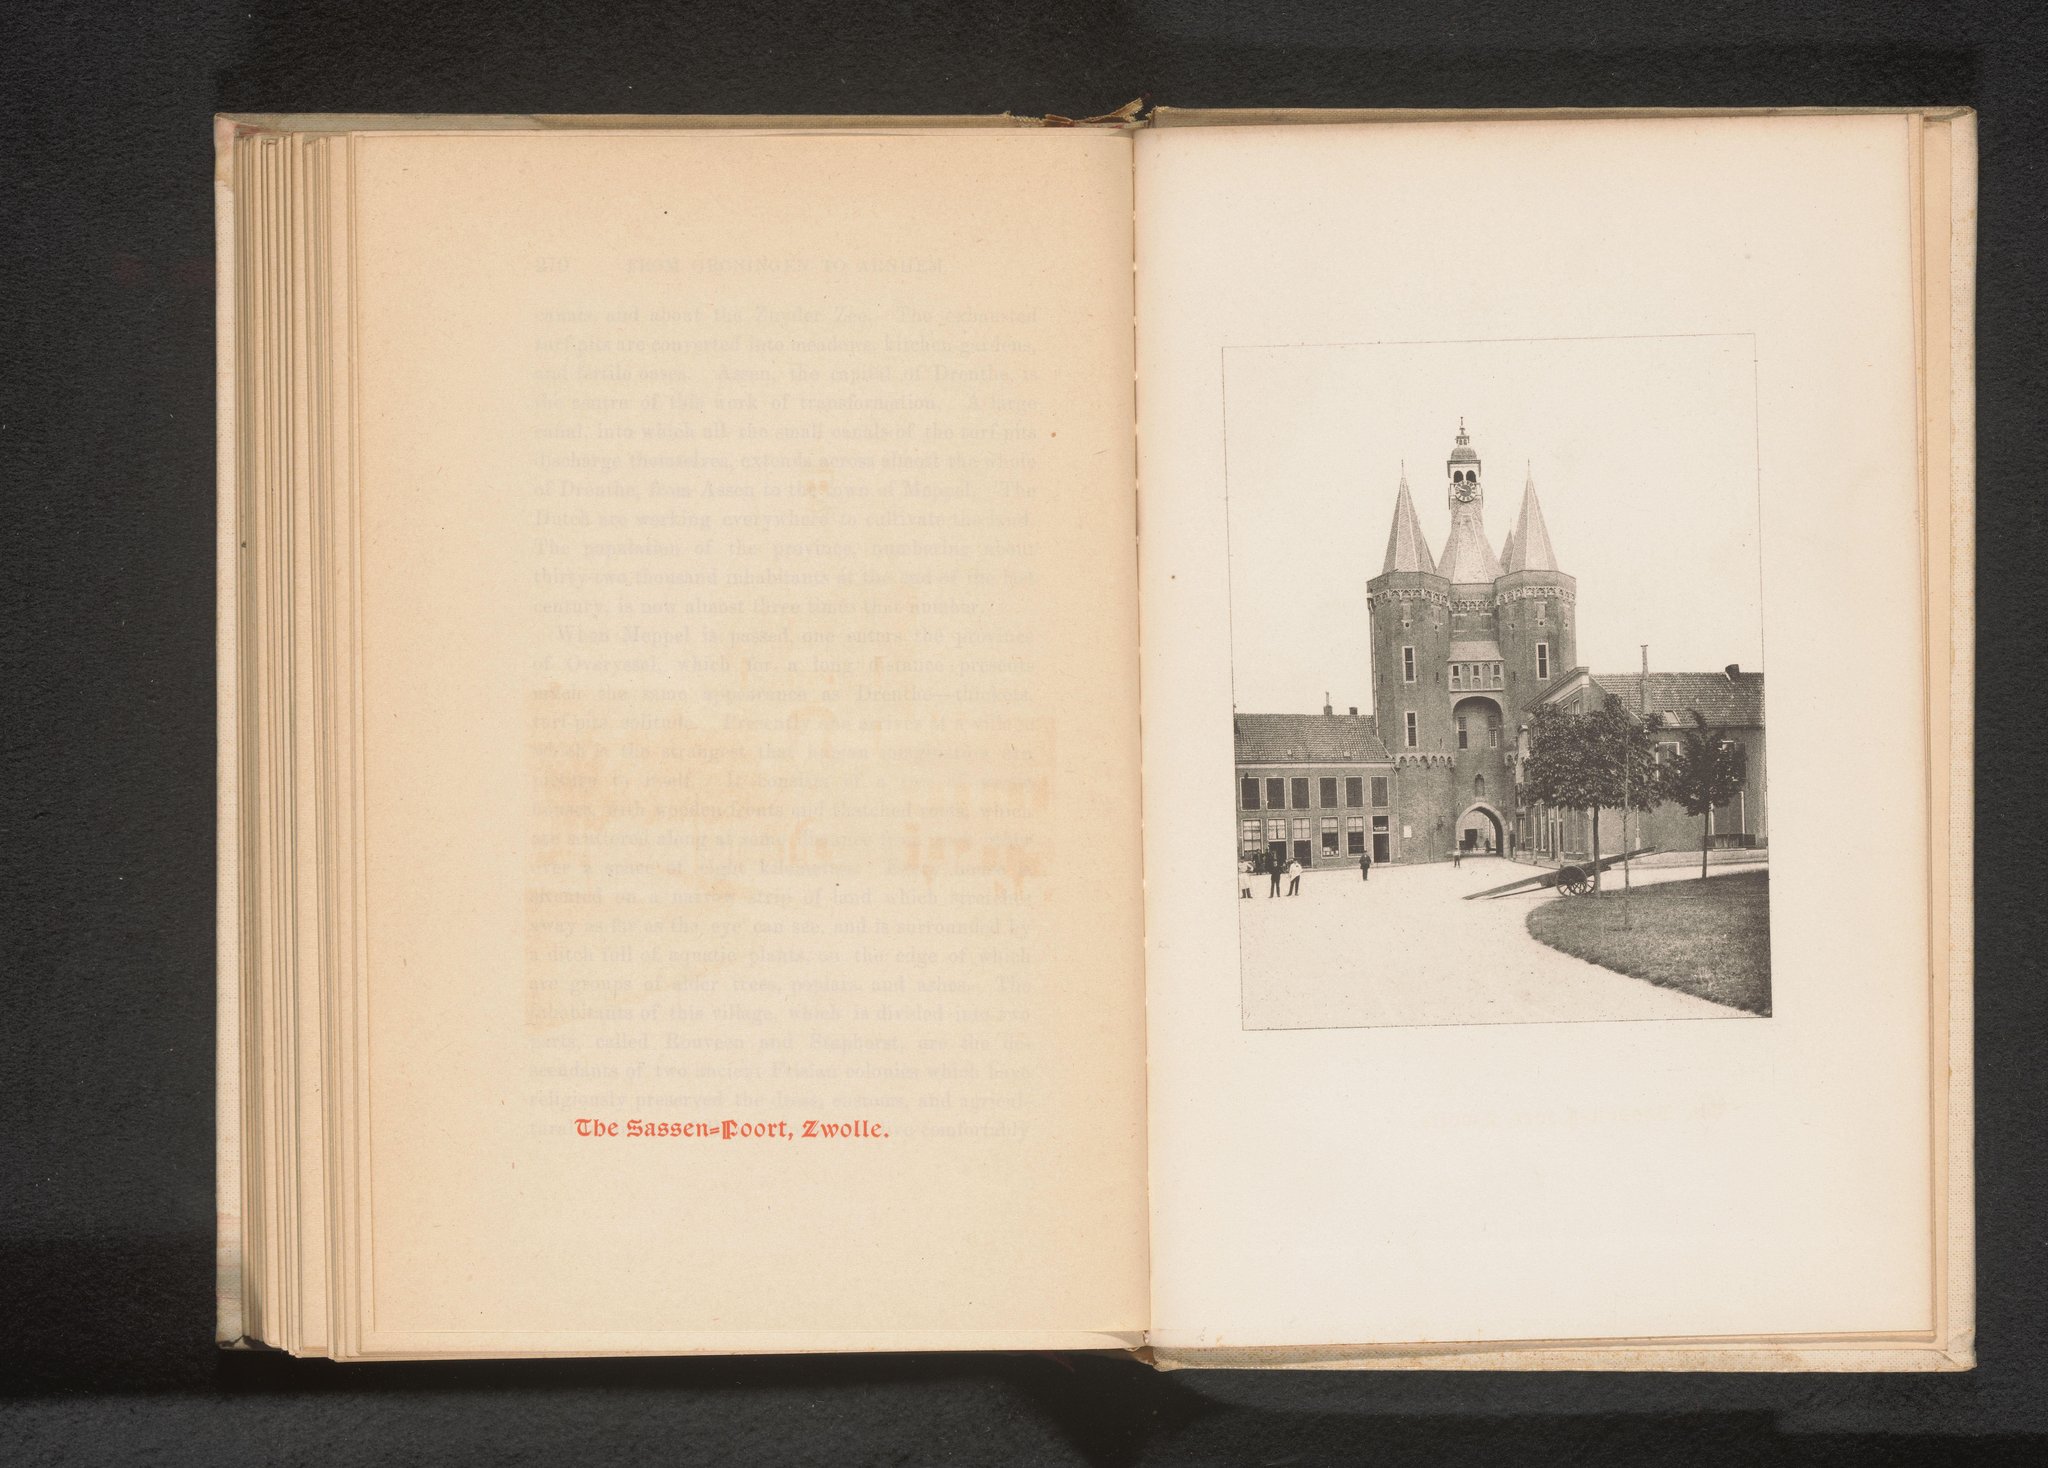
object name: page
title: Sassenpoort te Zwolle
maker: charles l. mitchell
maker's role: fotograaf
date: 1884-1894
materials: paper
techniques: photoaquatint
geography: zwolle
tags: gate ~ fortified city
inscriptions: title: ‘The Sassen-Poort, Zwolle.’